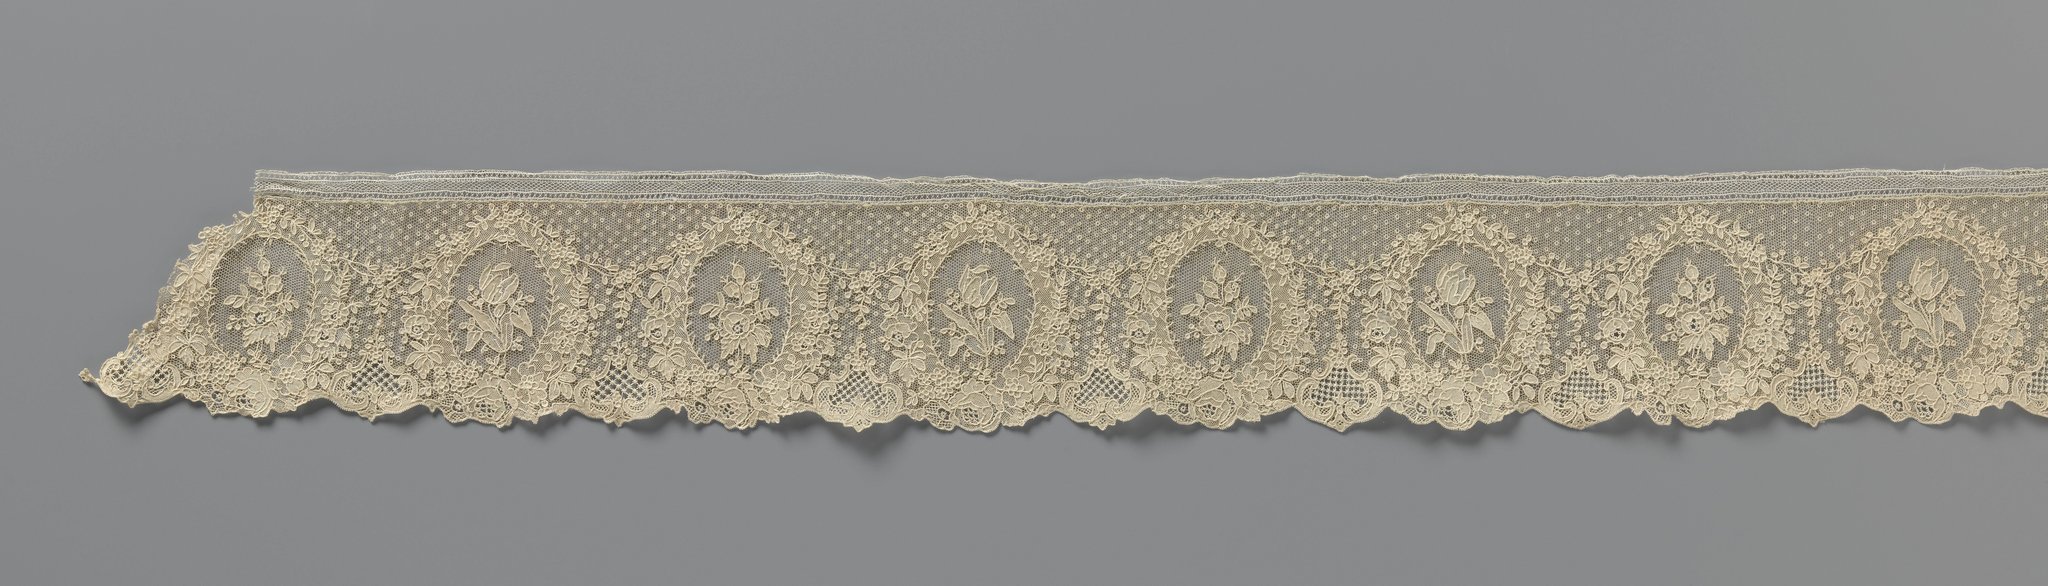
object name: strip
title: Strook naaldkant met tulp en rozentak in medaillons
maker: Anonymous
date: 1850-1860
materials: linen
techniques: lace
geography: alençon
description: Strook naturelkleurige naaldkant: Alençon-kant. Patroon met een repetitief motief van medaillons op een fijne zeshoekige maasgrond, die bovenin is bezaaid met moesjes. In de medaillons om en om een tulp en een rozentak. De buitenrand van de medaillons bestaat uit veelsoortige bloemen en bladeren die naar onder toe groter worden. Aan weerszijden van de grootste bloem onderaan een acanthusblad. Verschillende siergronden in de ruitvormige ruimtes tussen de acanthusbladeren en in een enkele bloem. Langs de onderrand bloemen, blaadjes die schulpen vormen. De bovenzijde is afgezet met een rand kloskant.